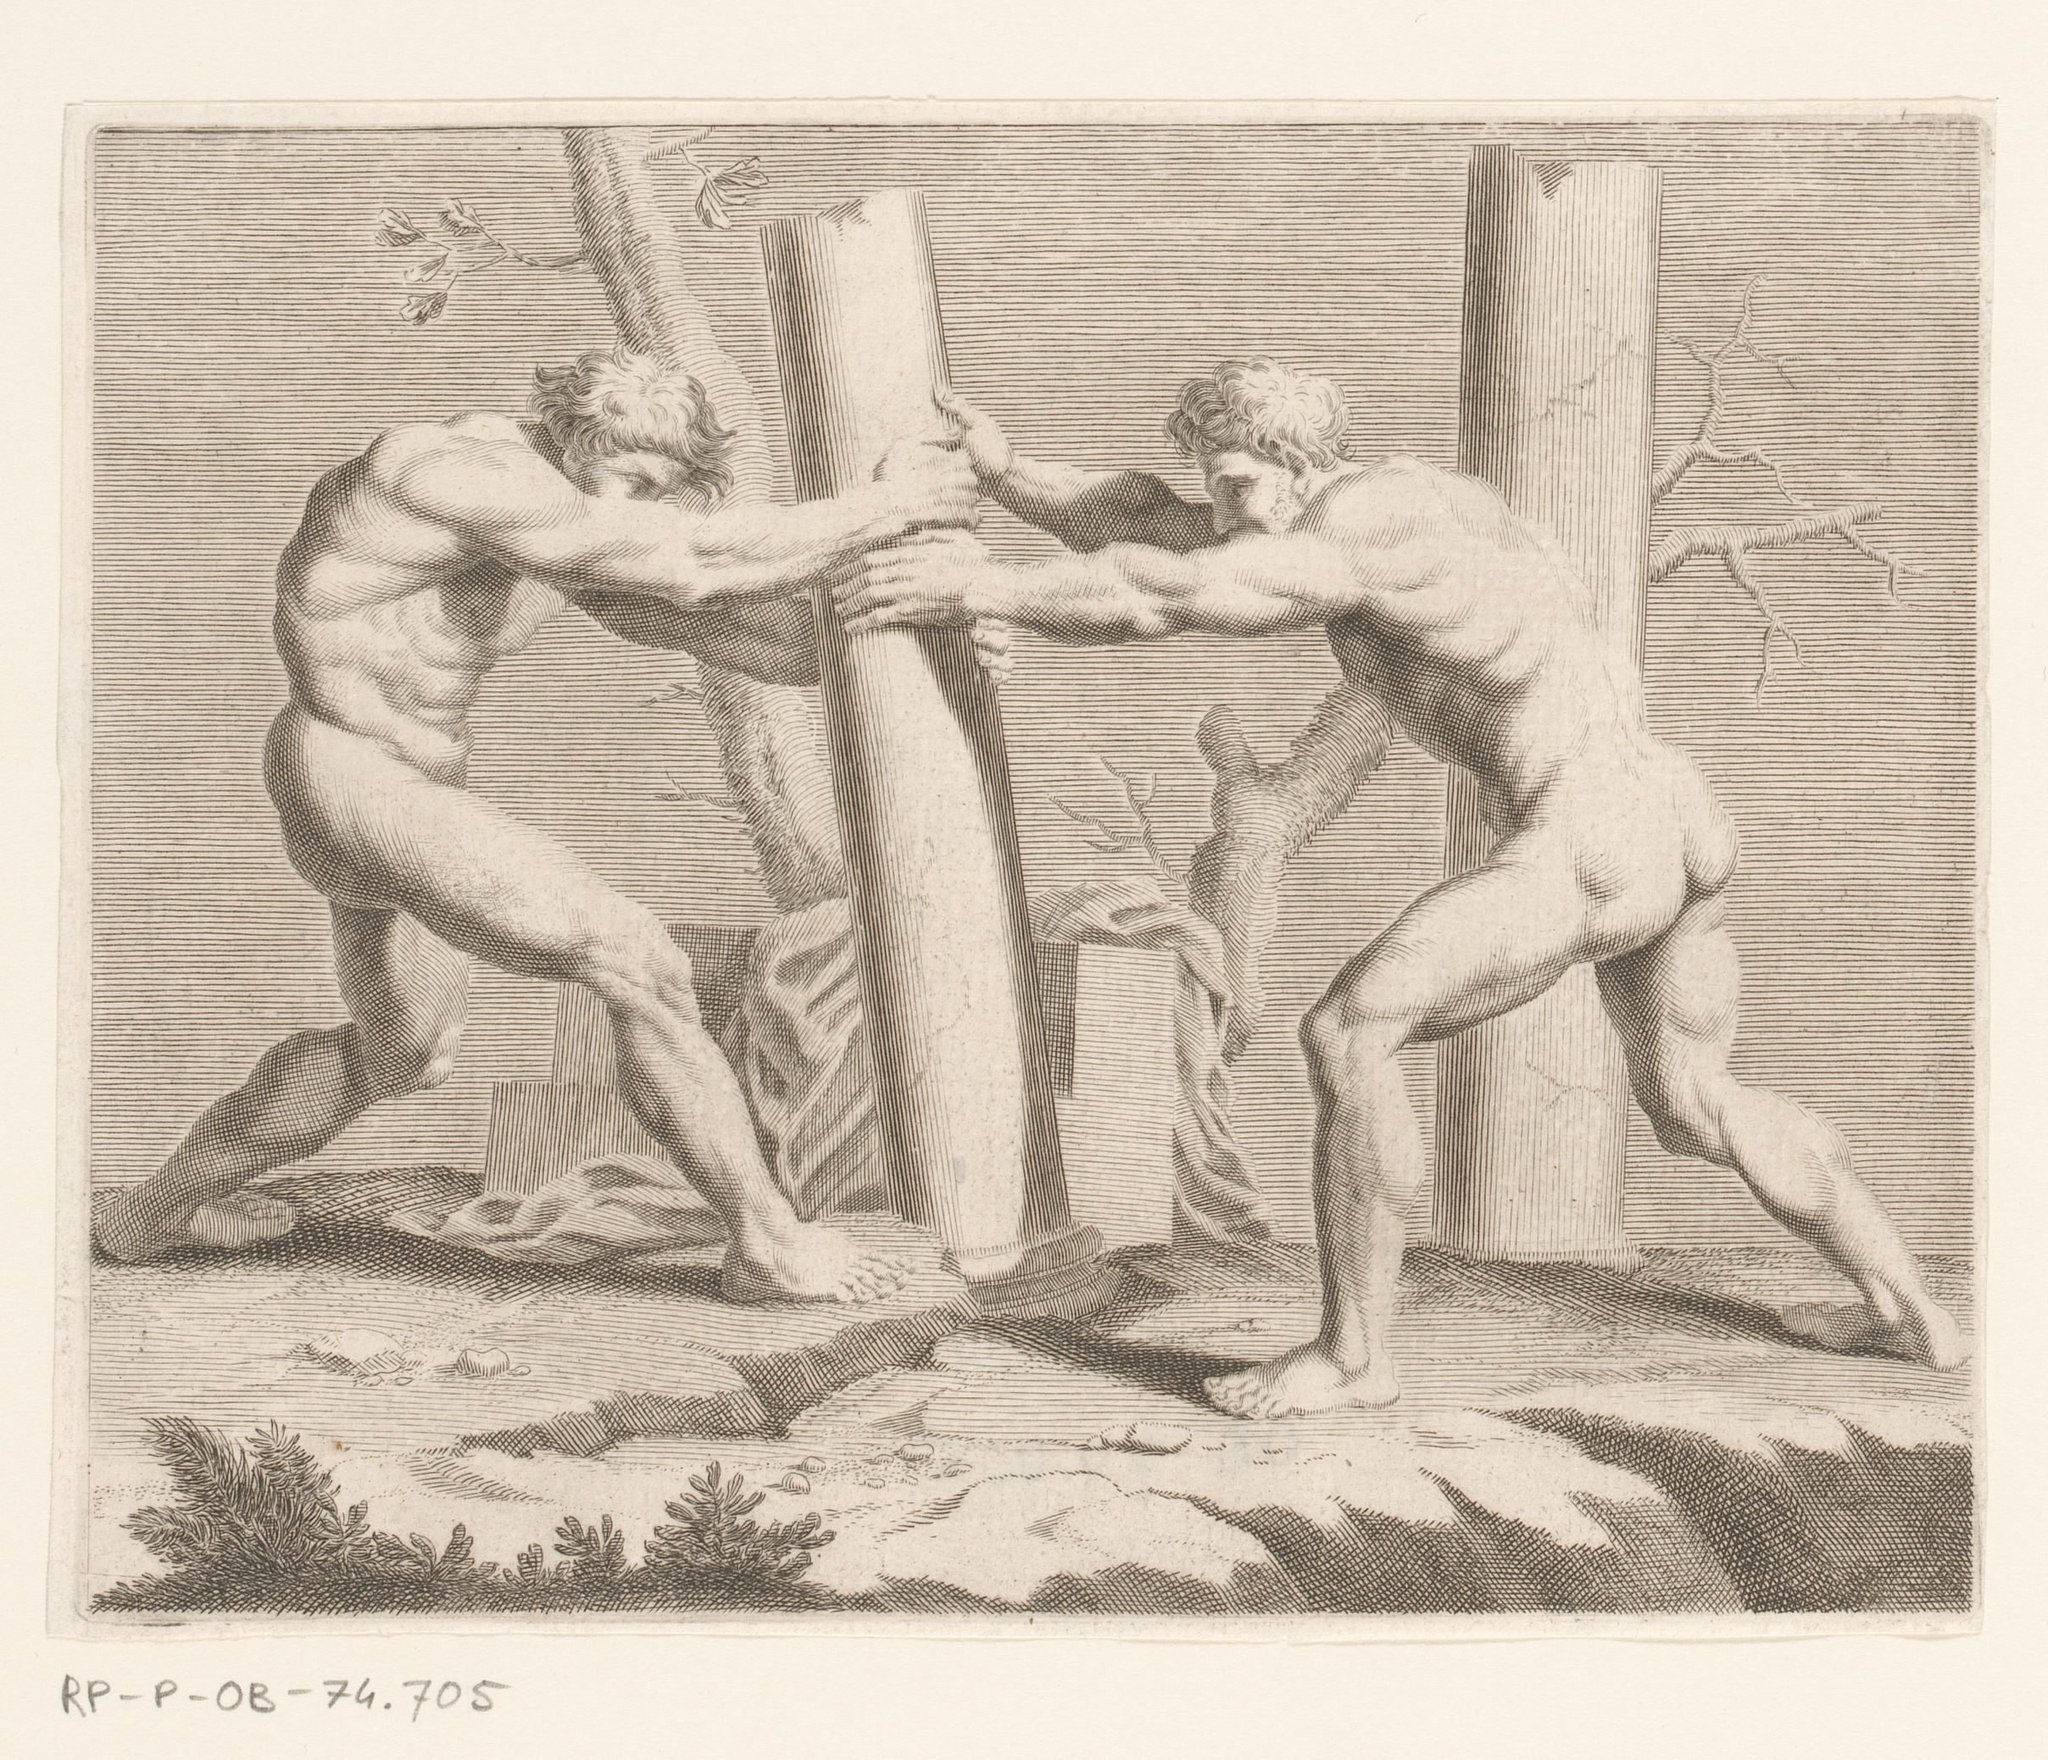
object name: print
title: Twee naakte mannen een zuil loswrikkend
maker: Anonymous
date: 1600-1699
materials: paper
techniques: engraving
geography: france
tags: column, pillar ~ architecture, man (showing himself) undressed, quasi-nude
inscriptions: collector's mark: Lugt 2228